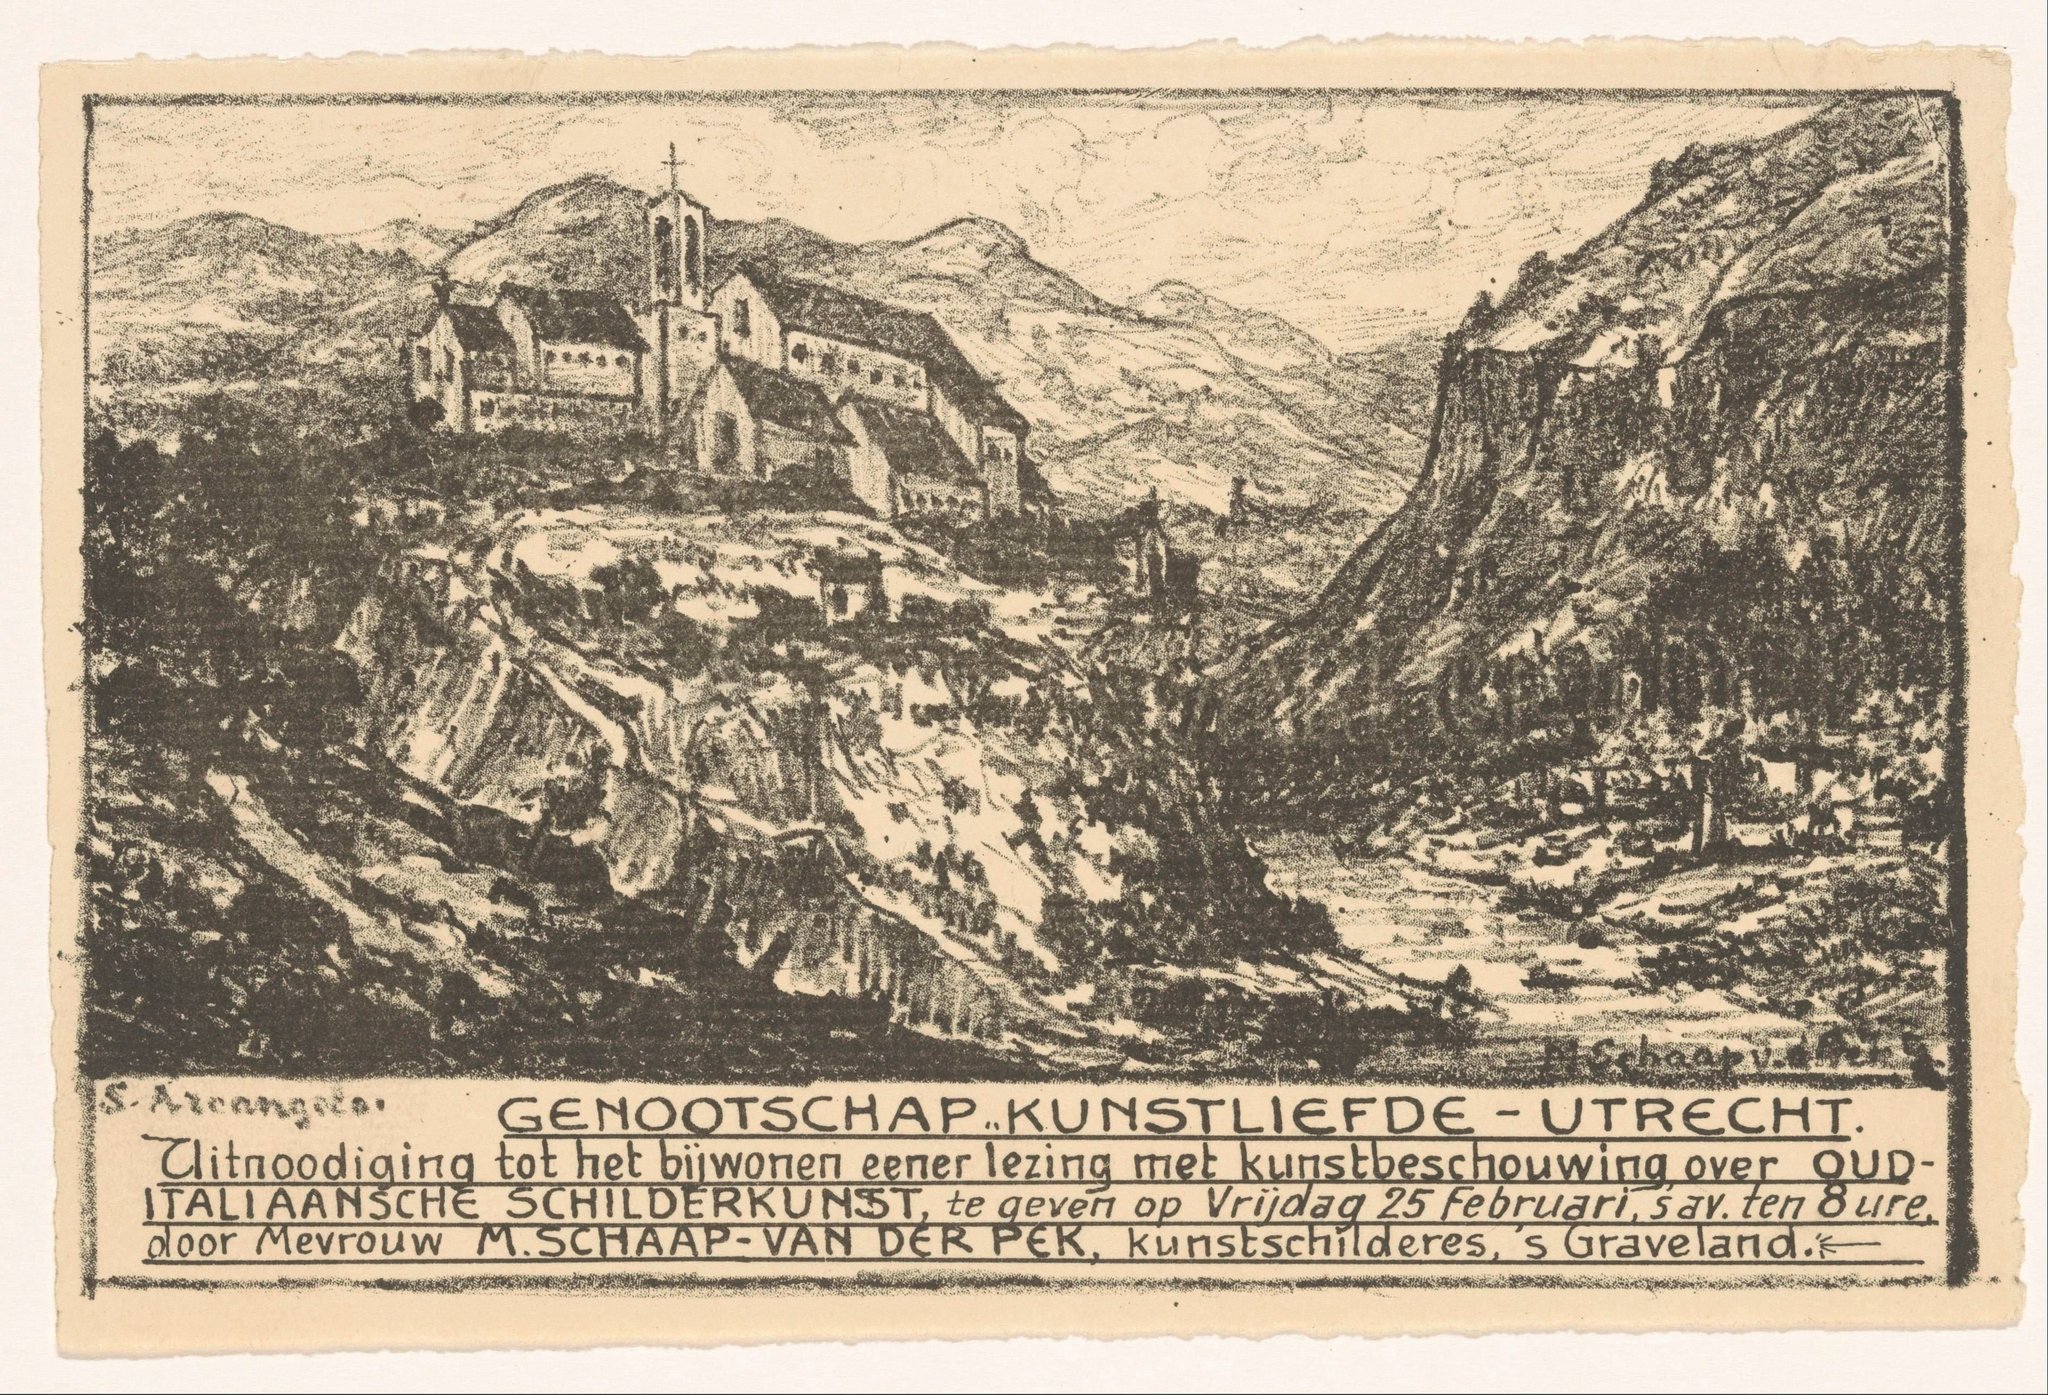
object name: print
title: S. Arcangelo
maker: h.w.j. schaap van der pek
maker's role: print maker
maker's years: 1867-1926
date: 1877-1926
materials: paper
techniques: lithograph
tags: amsterdam, print maker, hendrika van der pek, low hill country, abbey, monastery, convent ~ roman catholic church, italy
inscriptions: collector's mark: Lugt 2166, collector's mark: Lugt 2760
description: Een Italiaans heuvellandschap met een klooster.